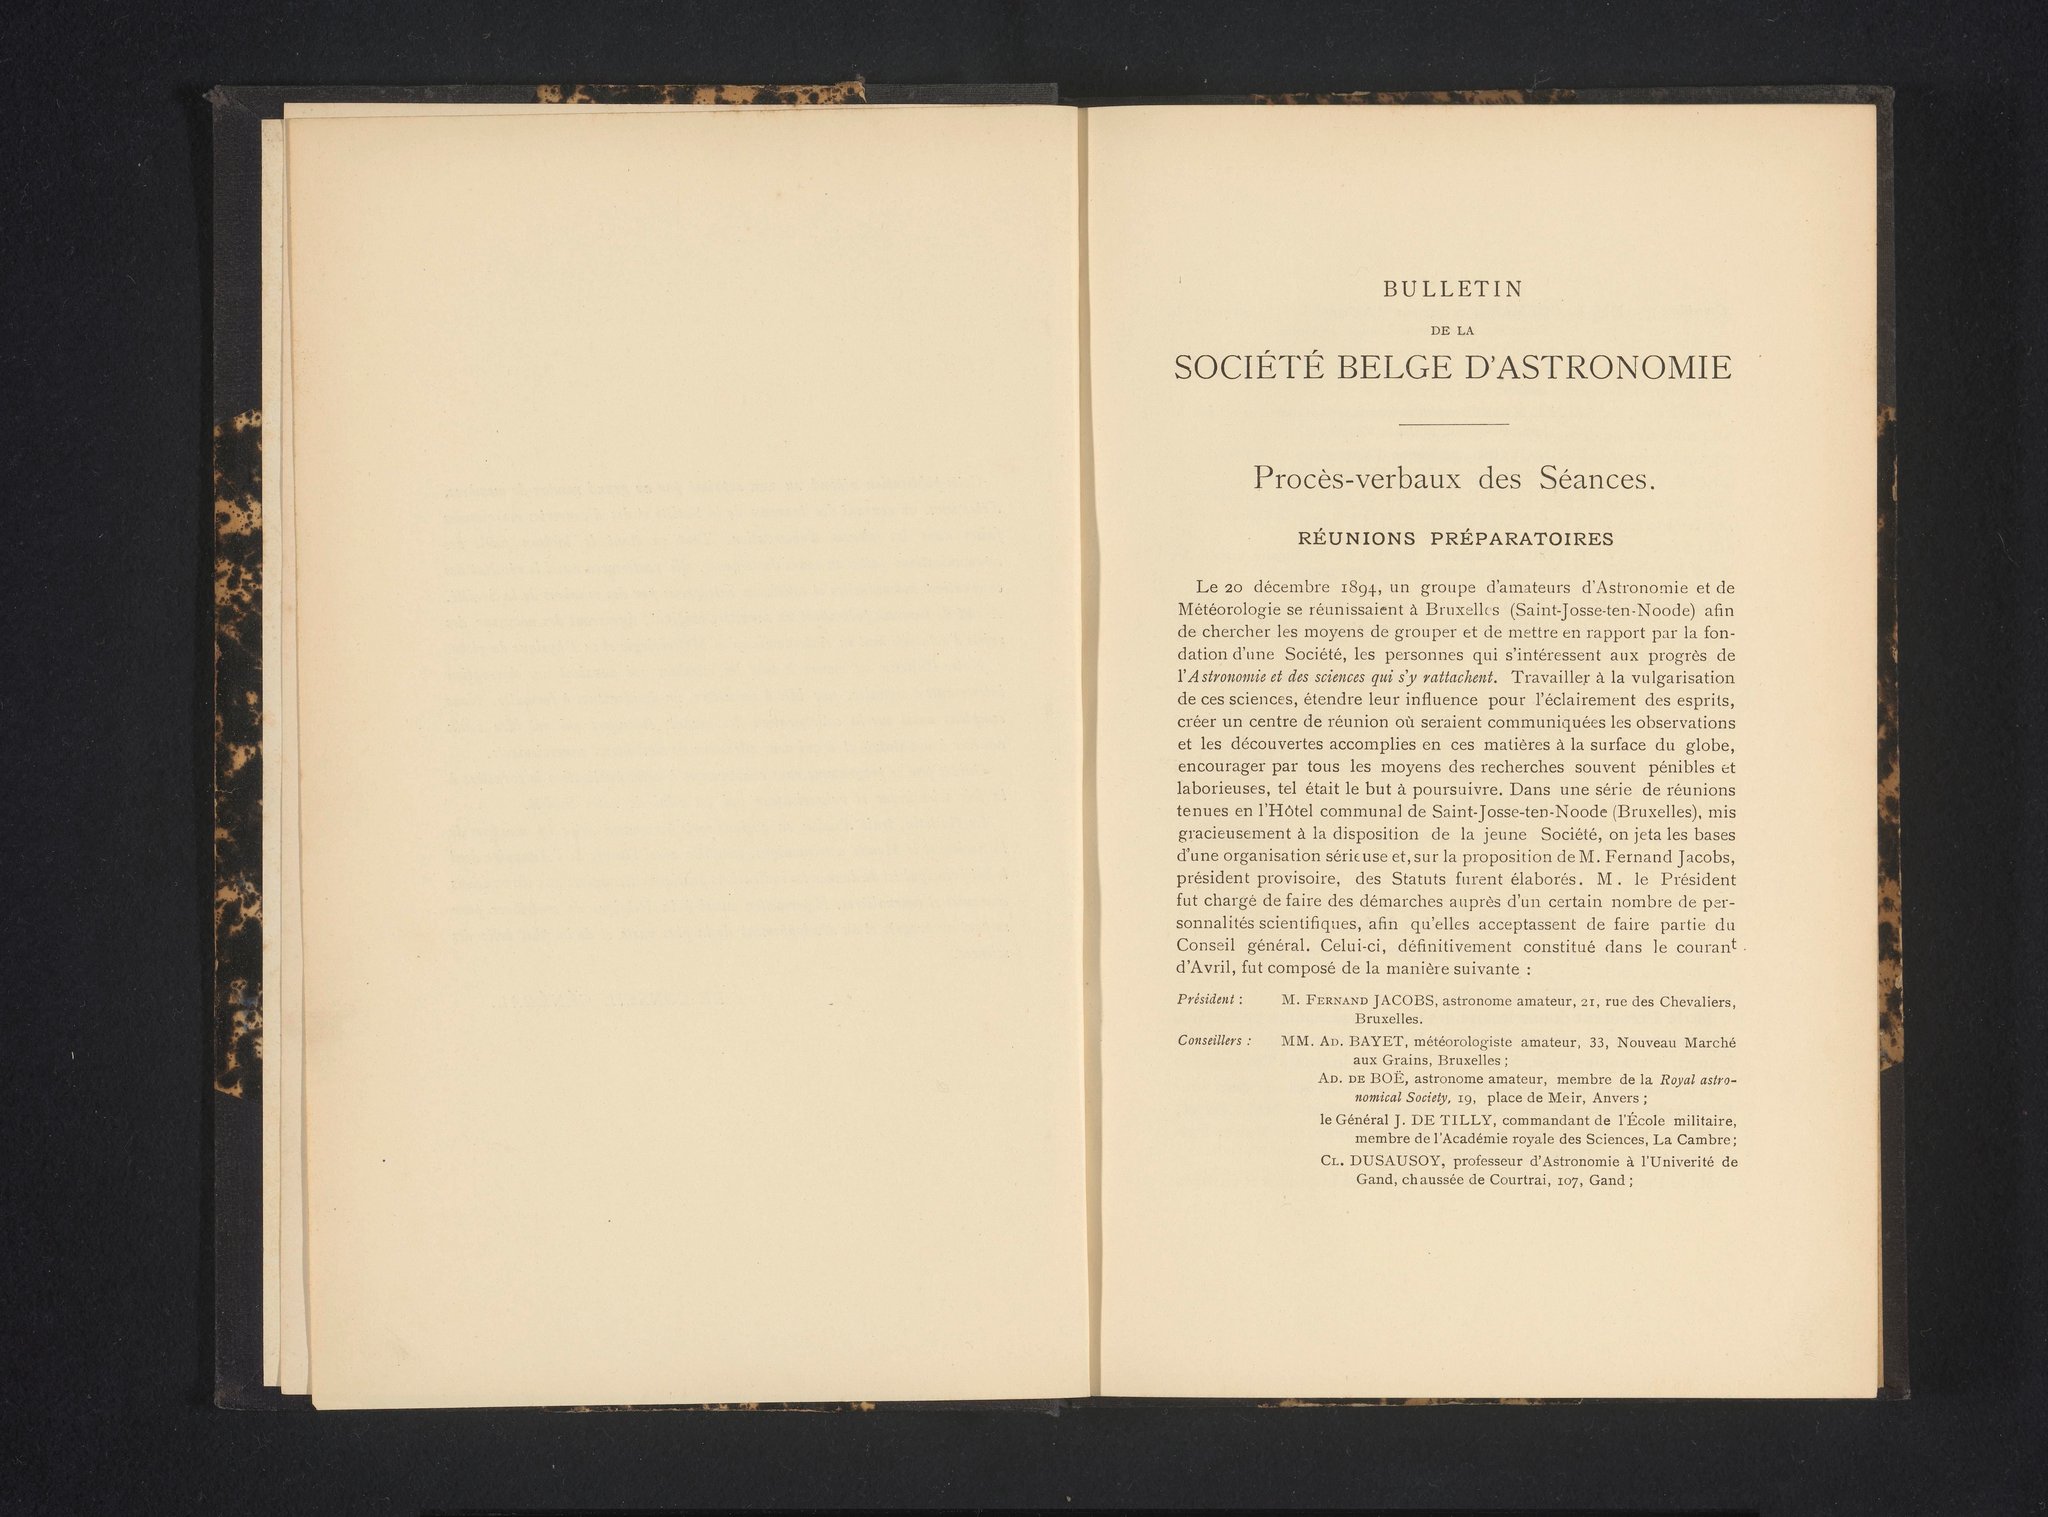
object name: magazine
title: Bulletin de la Société belge d'astronomie : comptes rendues des séances mensuelles de la Société et revue des sciences d'observation : astronomie, météorologie, géodésie et physique du globe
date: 1895-1896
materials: paper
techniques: marbled paper, photoaquatint, printing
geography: brussels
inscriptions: annotation: ‘APR/ 1991’